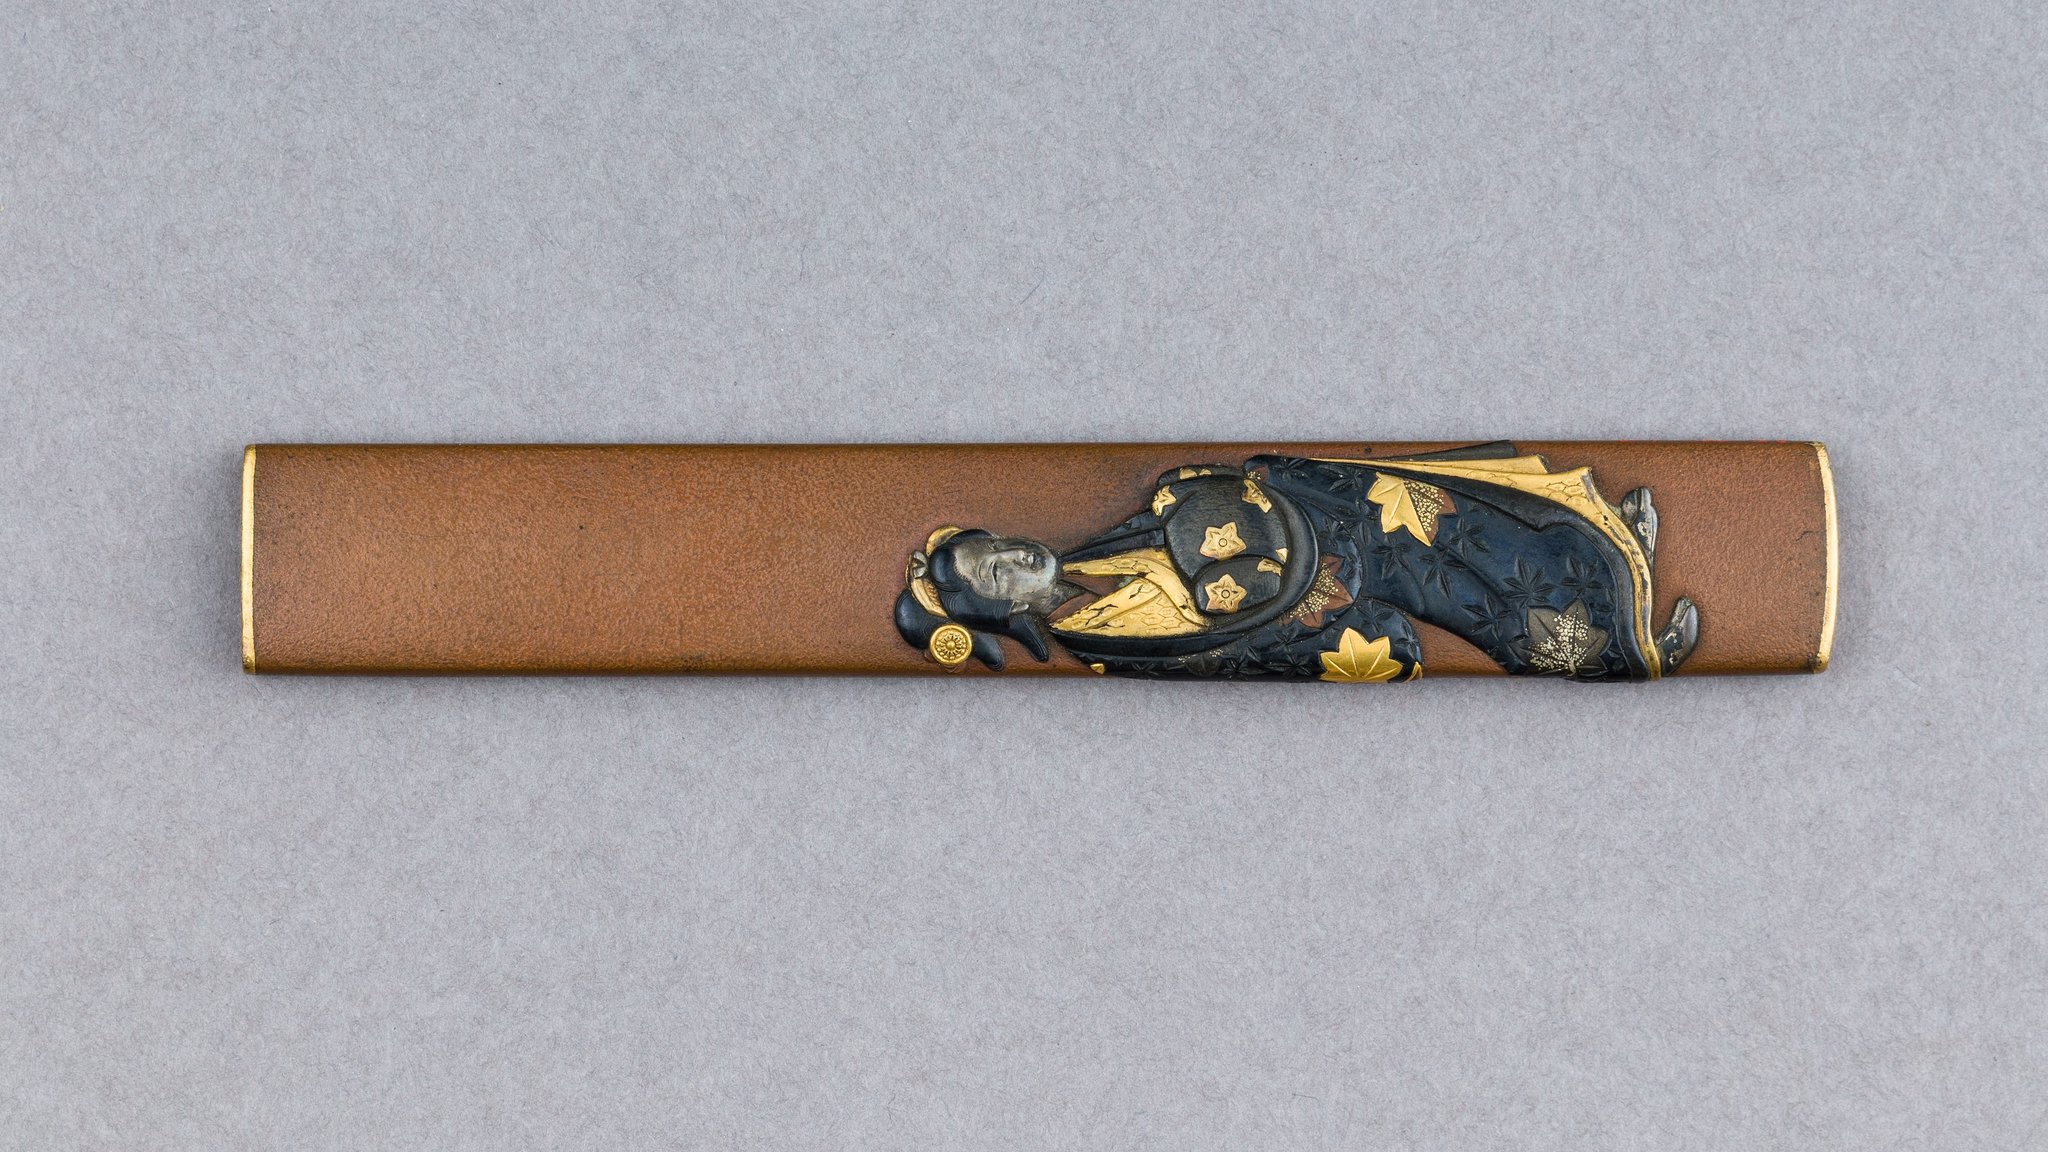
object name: knife handle kozuka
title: Knife Handle (Kozuka)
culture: japanese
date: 1801-1900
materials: copper, gold alloy, silver alloy, gold, silver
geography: japan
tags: women